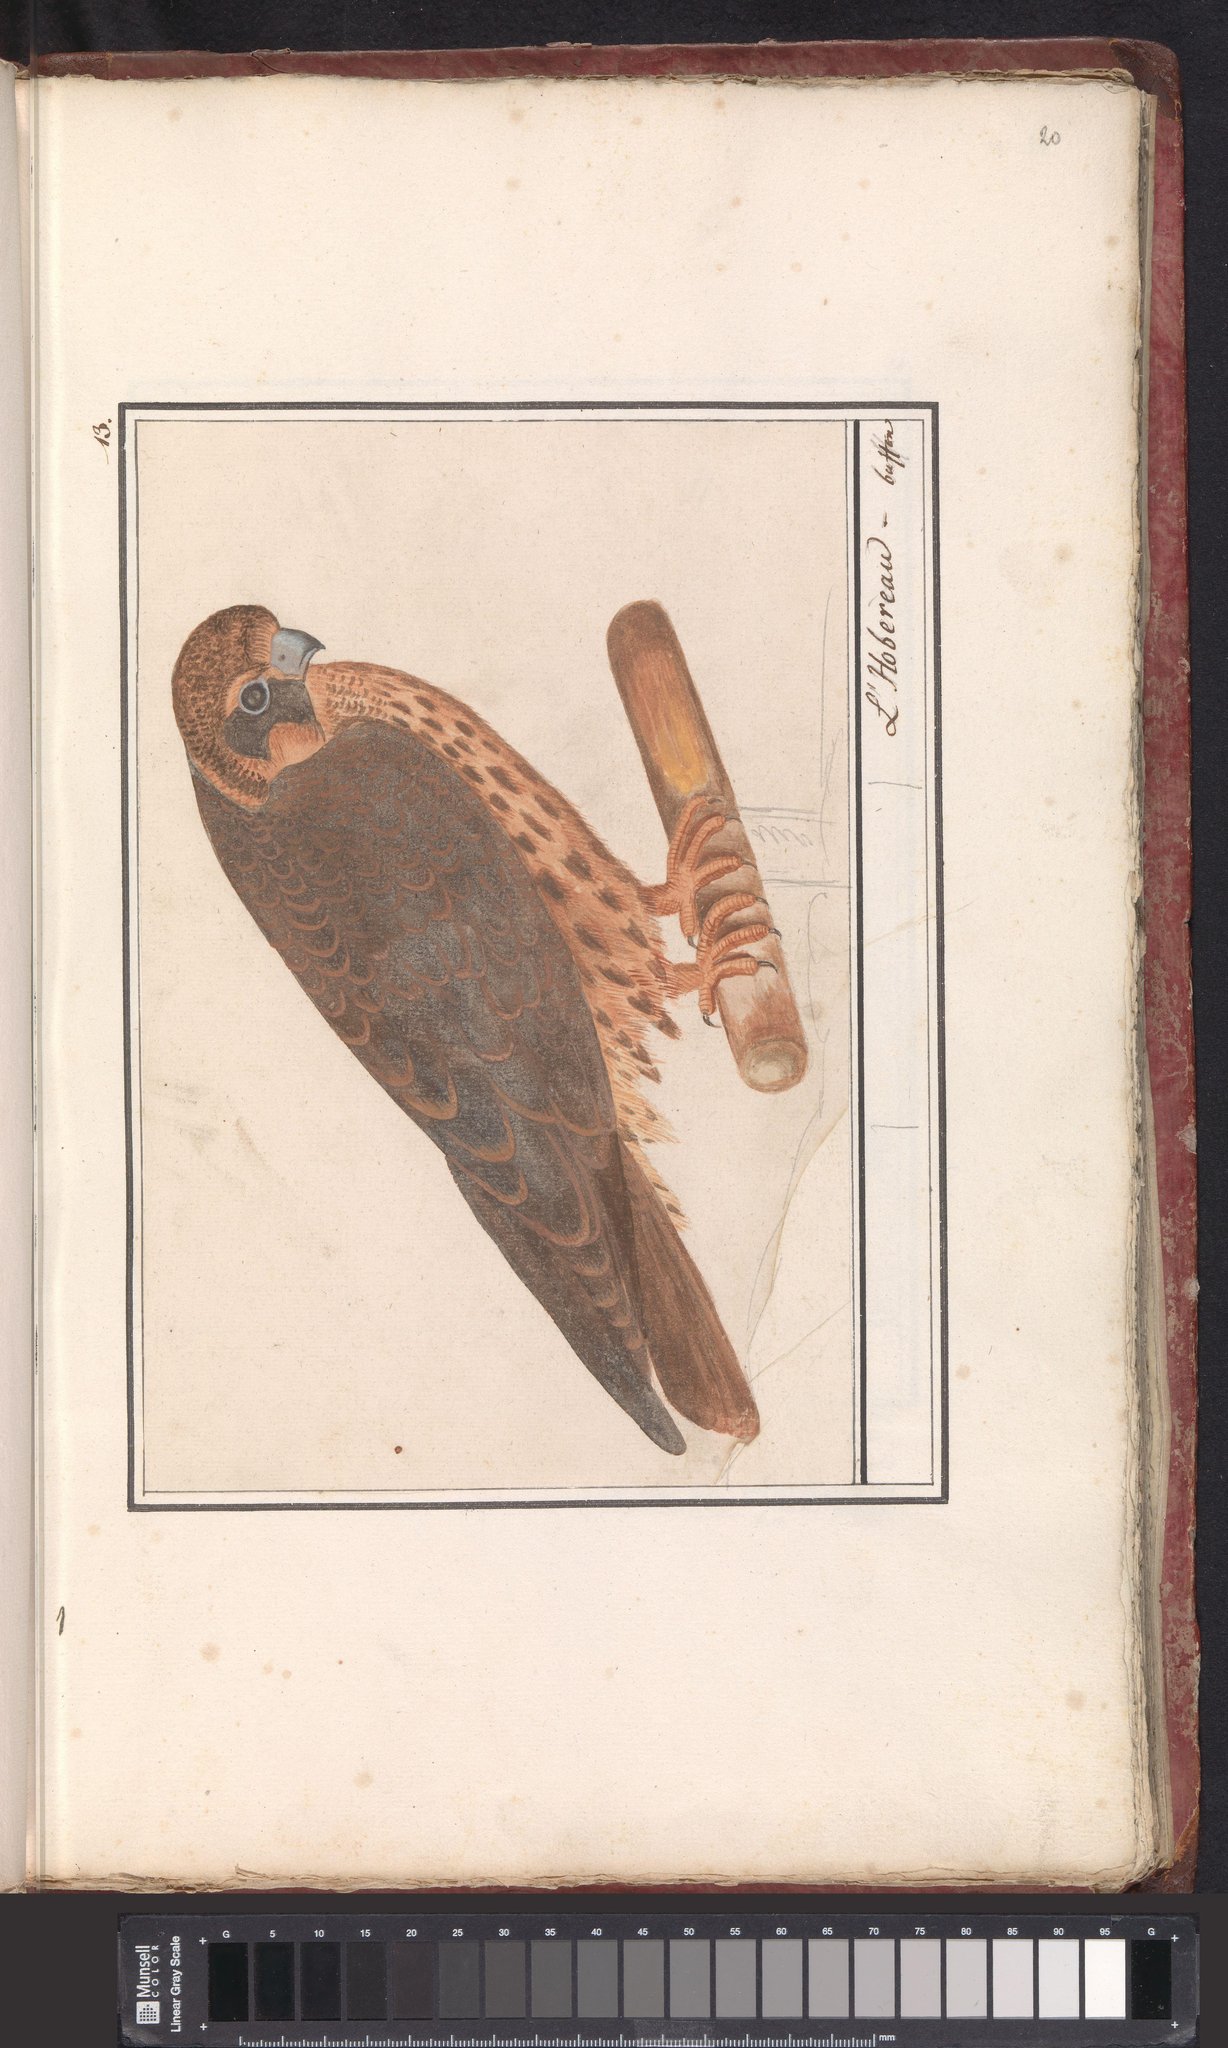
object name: drawing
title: L'Hobereau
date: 1596-1610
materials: paint, paper, pencil, watercolor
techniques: brush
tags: predatory birds: eurasian hobby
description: Boomvalk. Genummerd rechtsboven: 13. Onderdeel van het eerste album met tekeningen van vogels. Derde van twaalf albums met tekeningen van dieren, vogels en planten bekend rond 1600, gemaakt in opdracht van keizer Rudolf II. Met toelichting in Nederlands, Latijn en Frans.